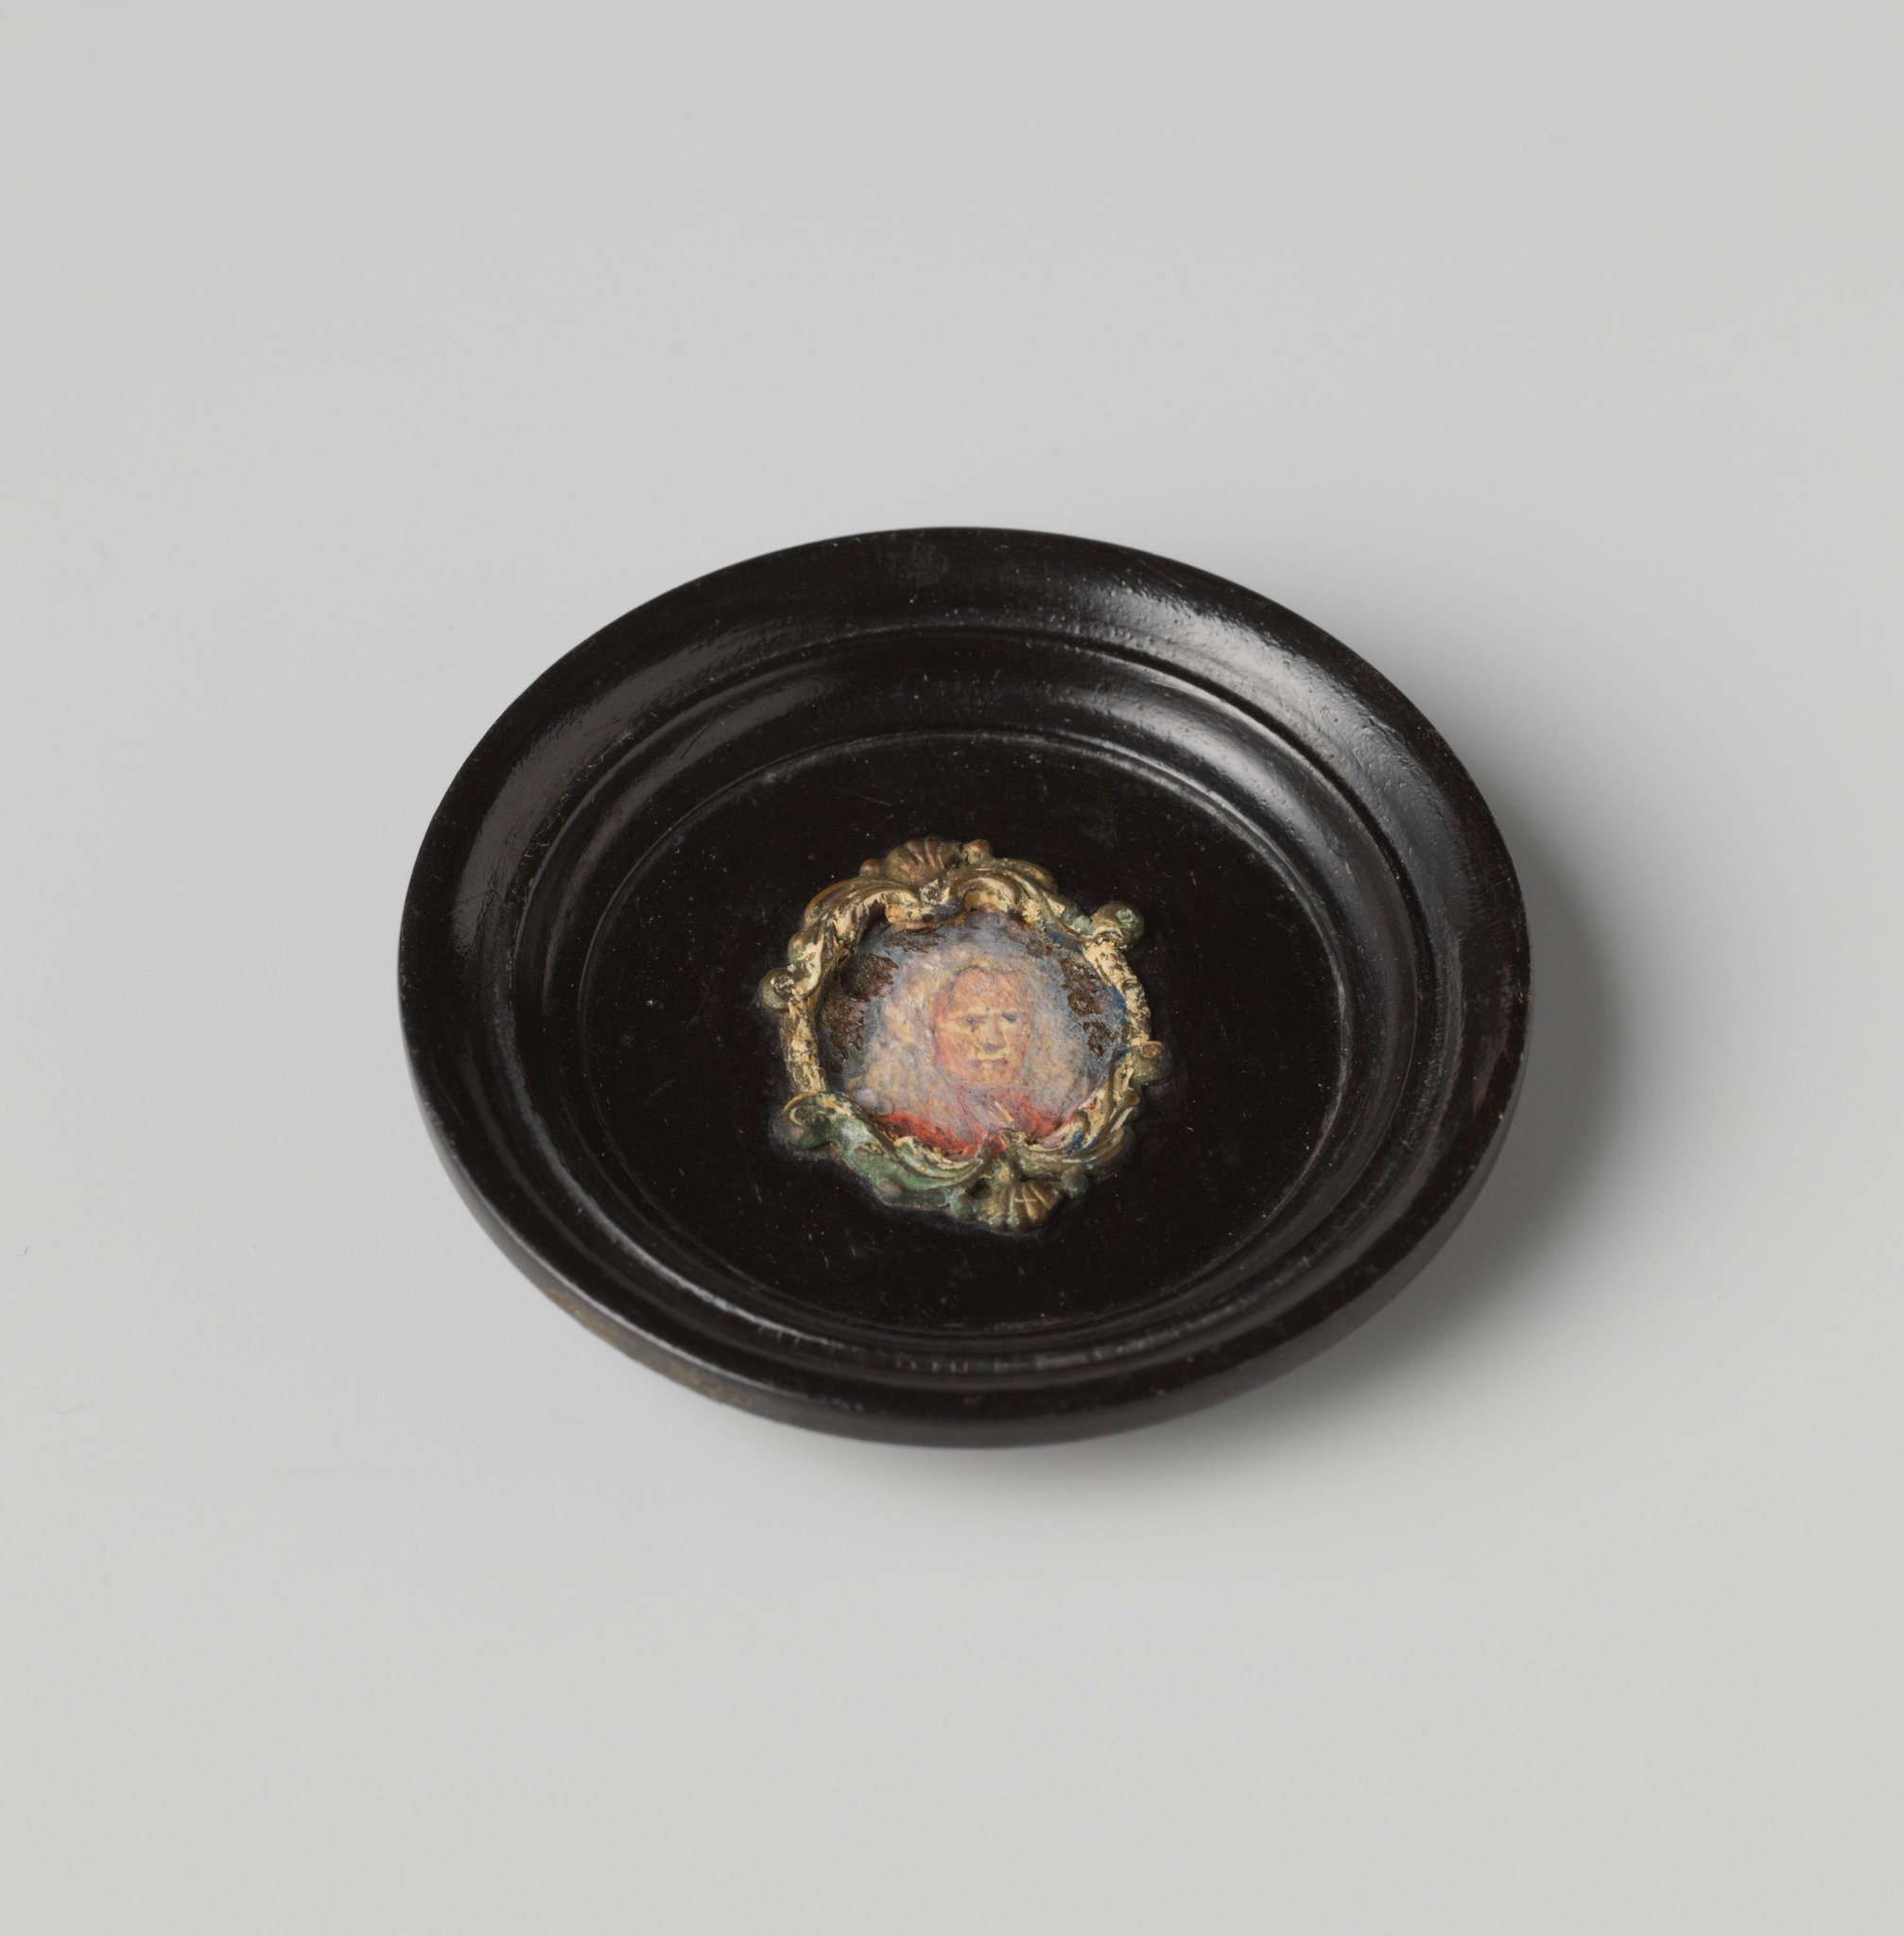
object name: painting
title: Portret van een onbekende man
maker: Anonymous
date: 1675-1699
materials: copper, oil, paper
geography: netherlands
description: Een portret van een man, ingelijst in een houten ronde lijst, versierd met bloem- en bladranken.